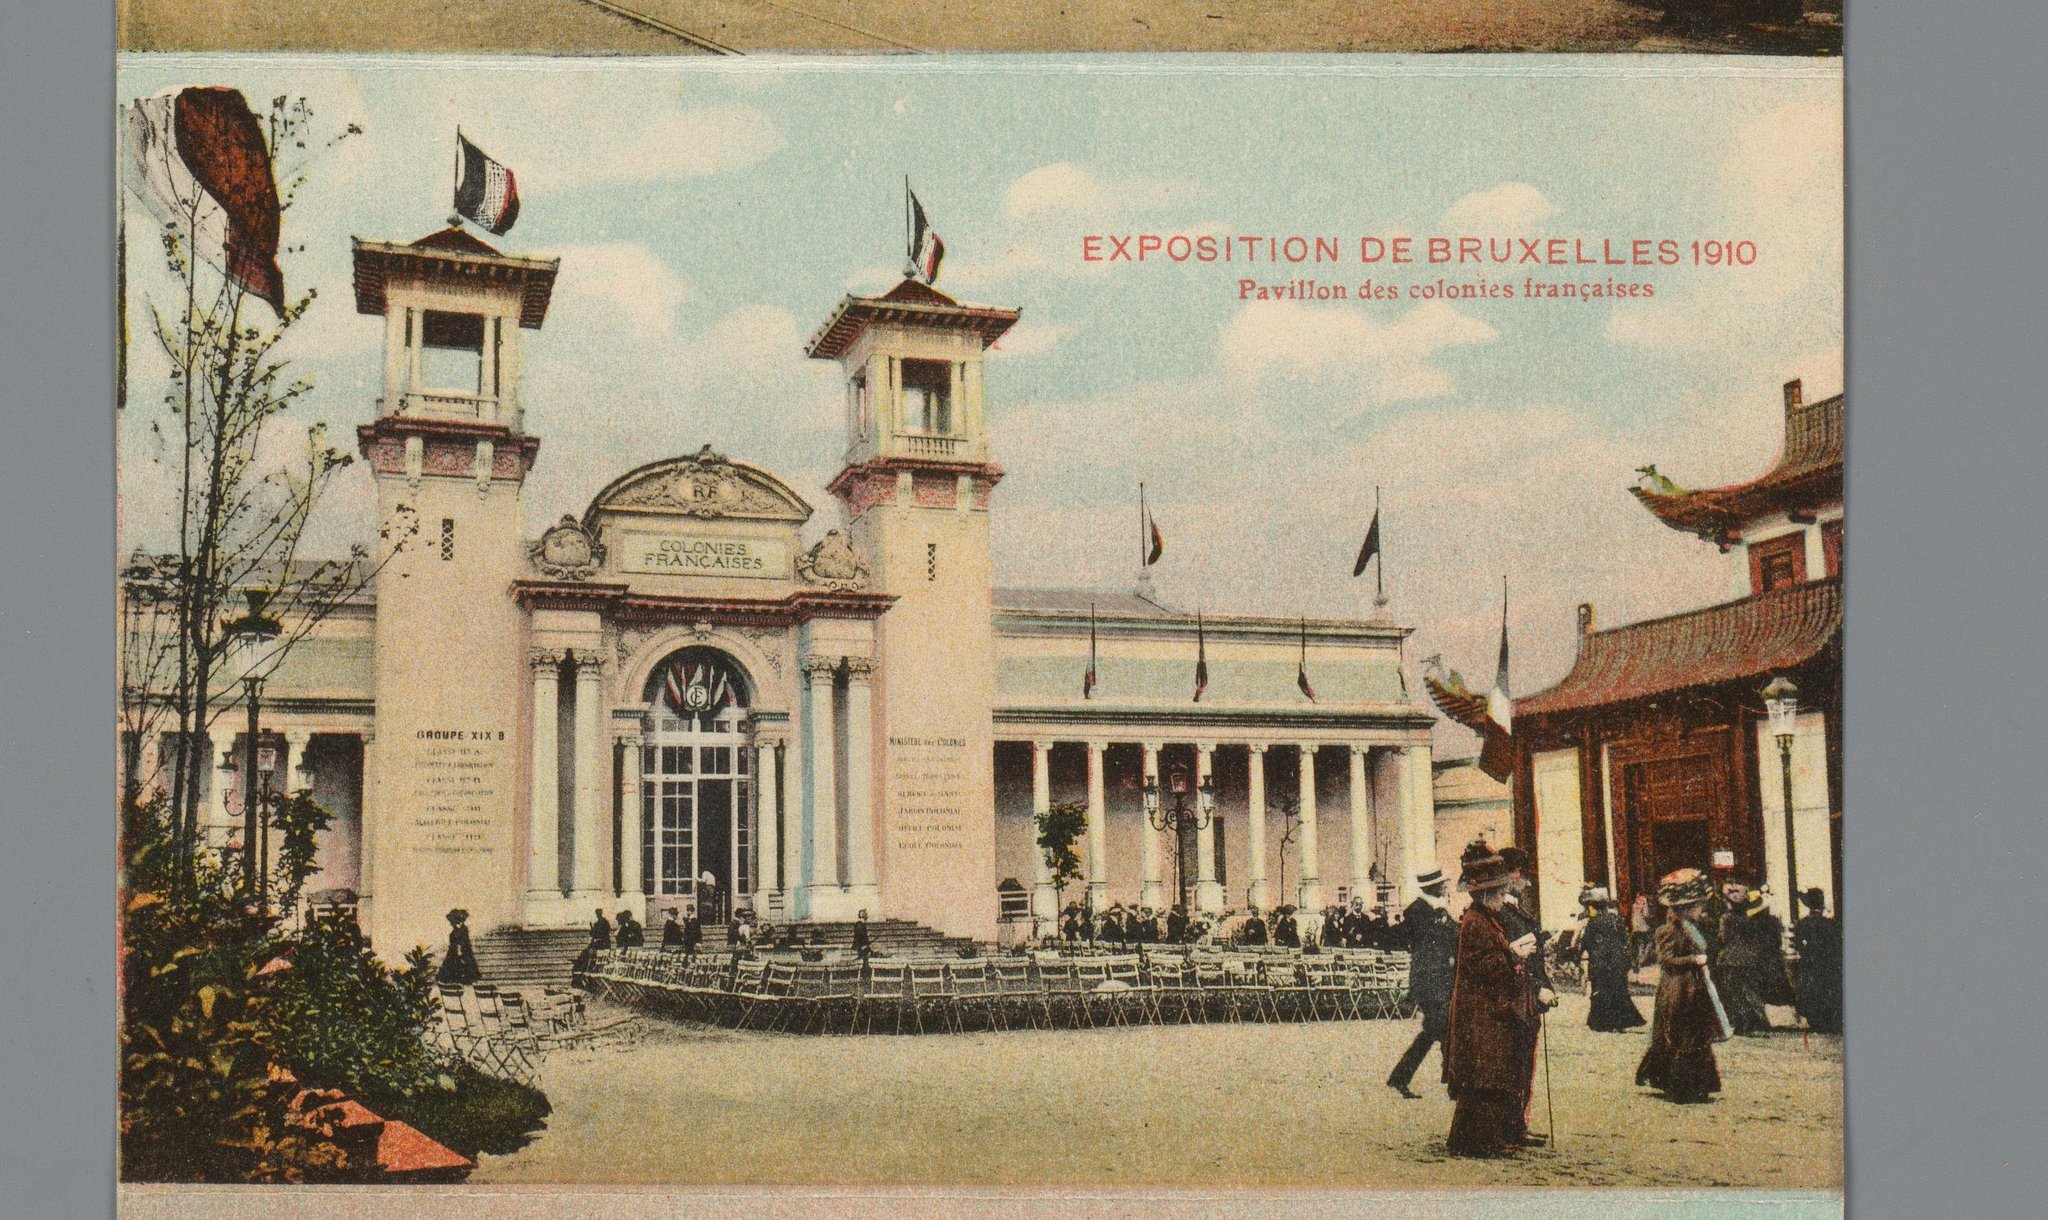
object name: ansichtkaart, prentbriefkaart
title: Pavillon des colonies françaises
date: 1910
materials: cardboard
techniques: photograph, lithograph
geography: brussels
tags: world fair, world exhibition, edifice, e.g.: public building, department store, brussels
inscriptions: date